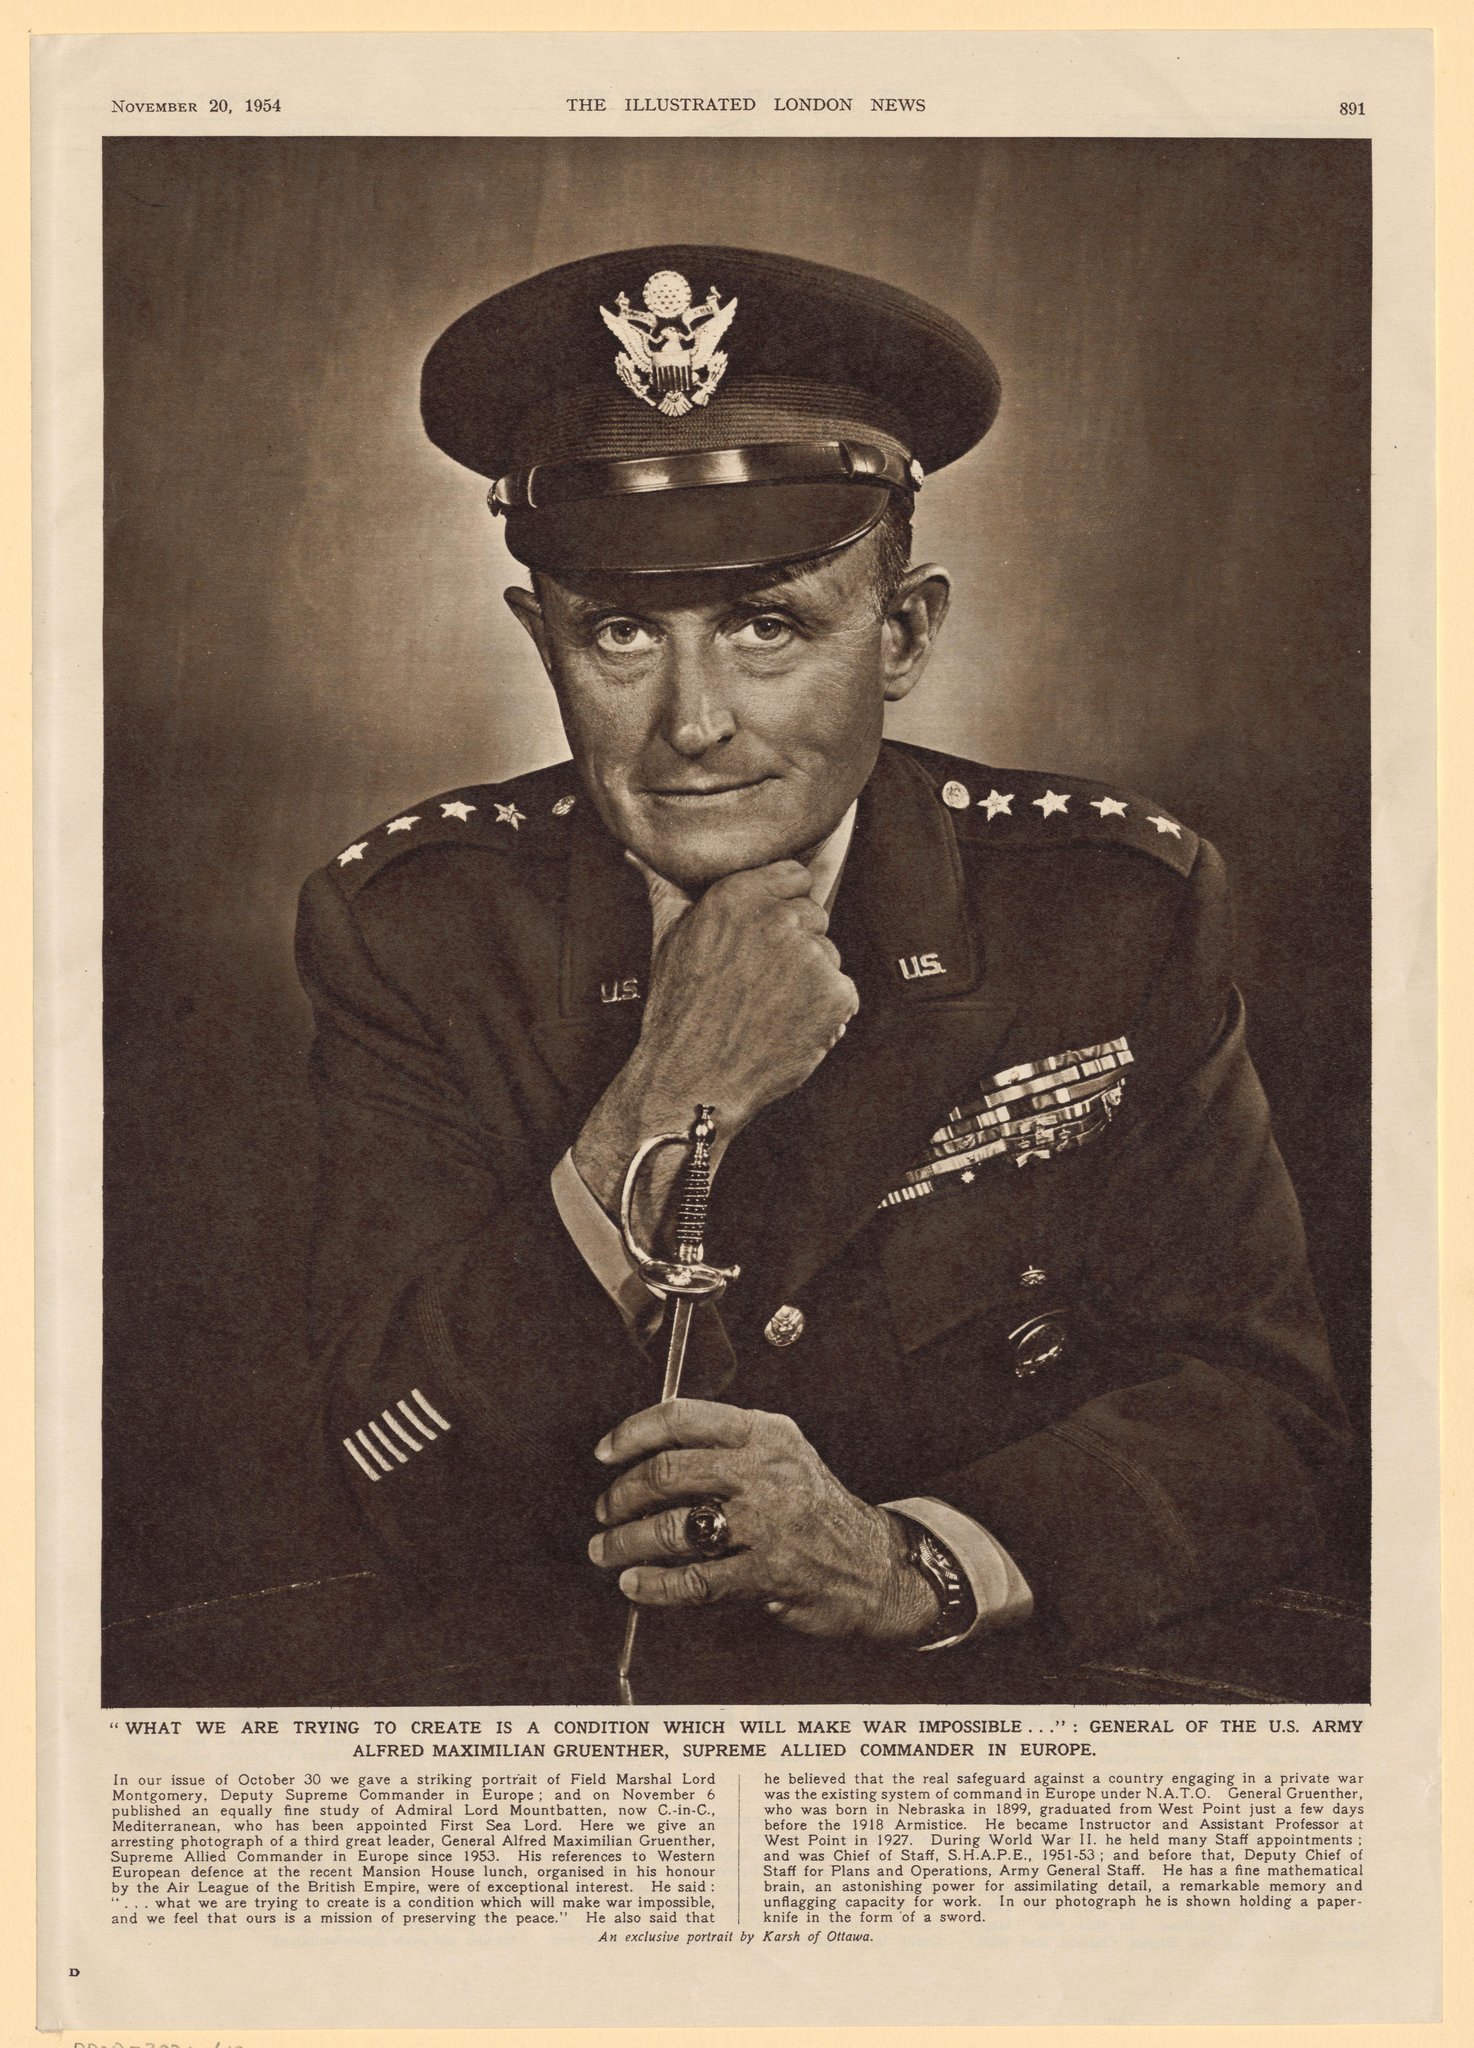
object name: photomechanical print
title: Portret van Alfred Gruenther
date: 1953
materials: paper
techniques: letterpress printing, rotogravure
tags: historical persons, commander-in-chief, admiral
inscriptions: date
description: Prent uit: The Illustrated London News, 20 november 1954, p. 891. Op verso onder de sectie 'The World of Science' een artikel over Portugese oorlogsschepen geïllustreerd met rotogravures.